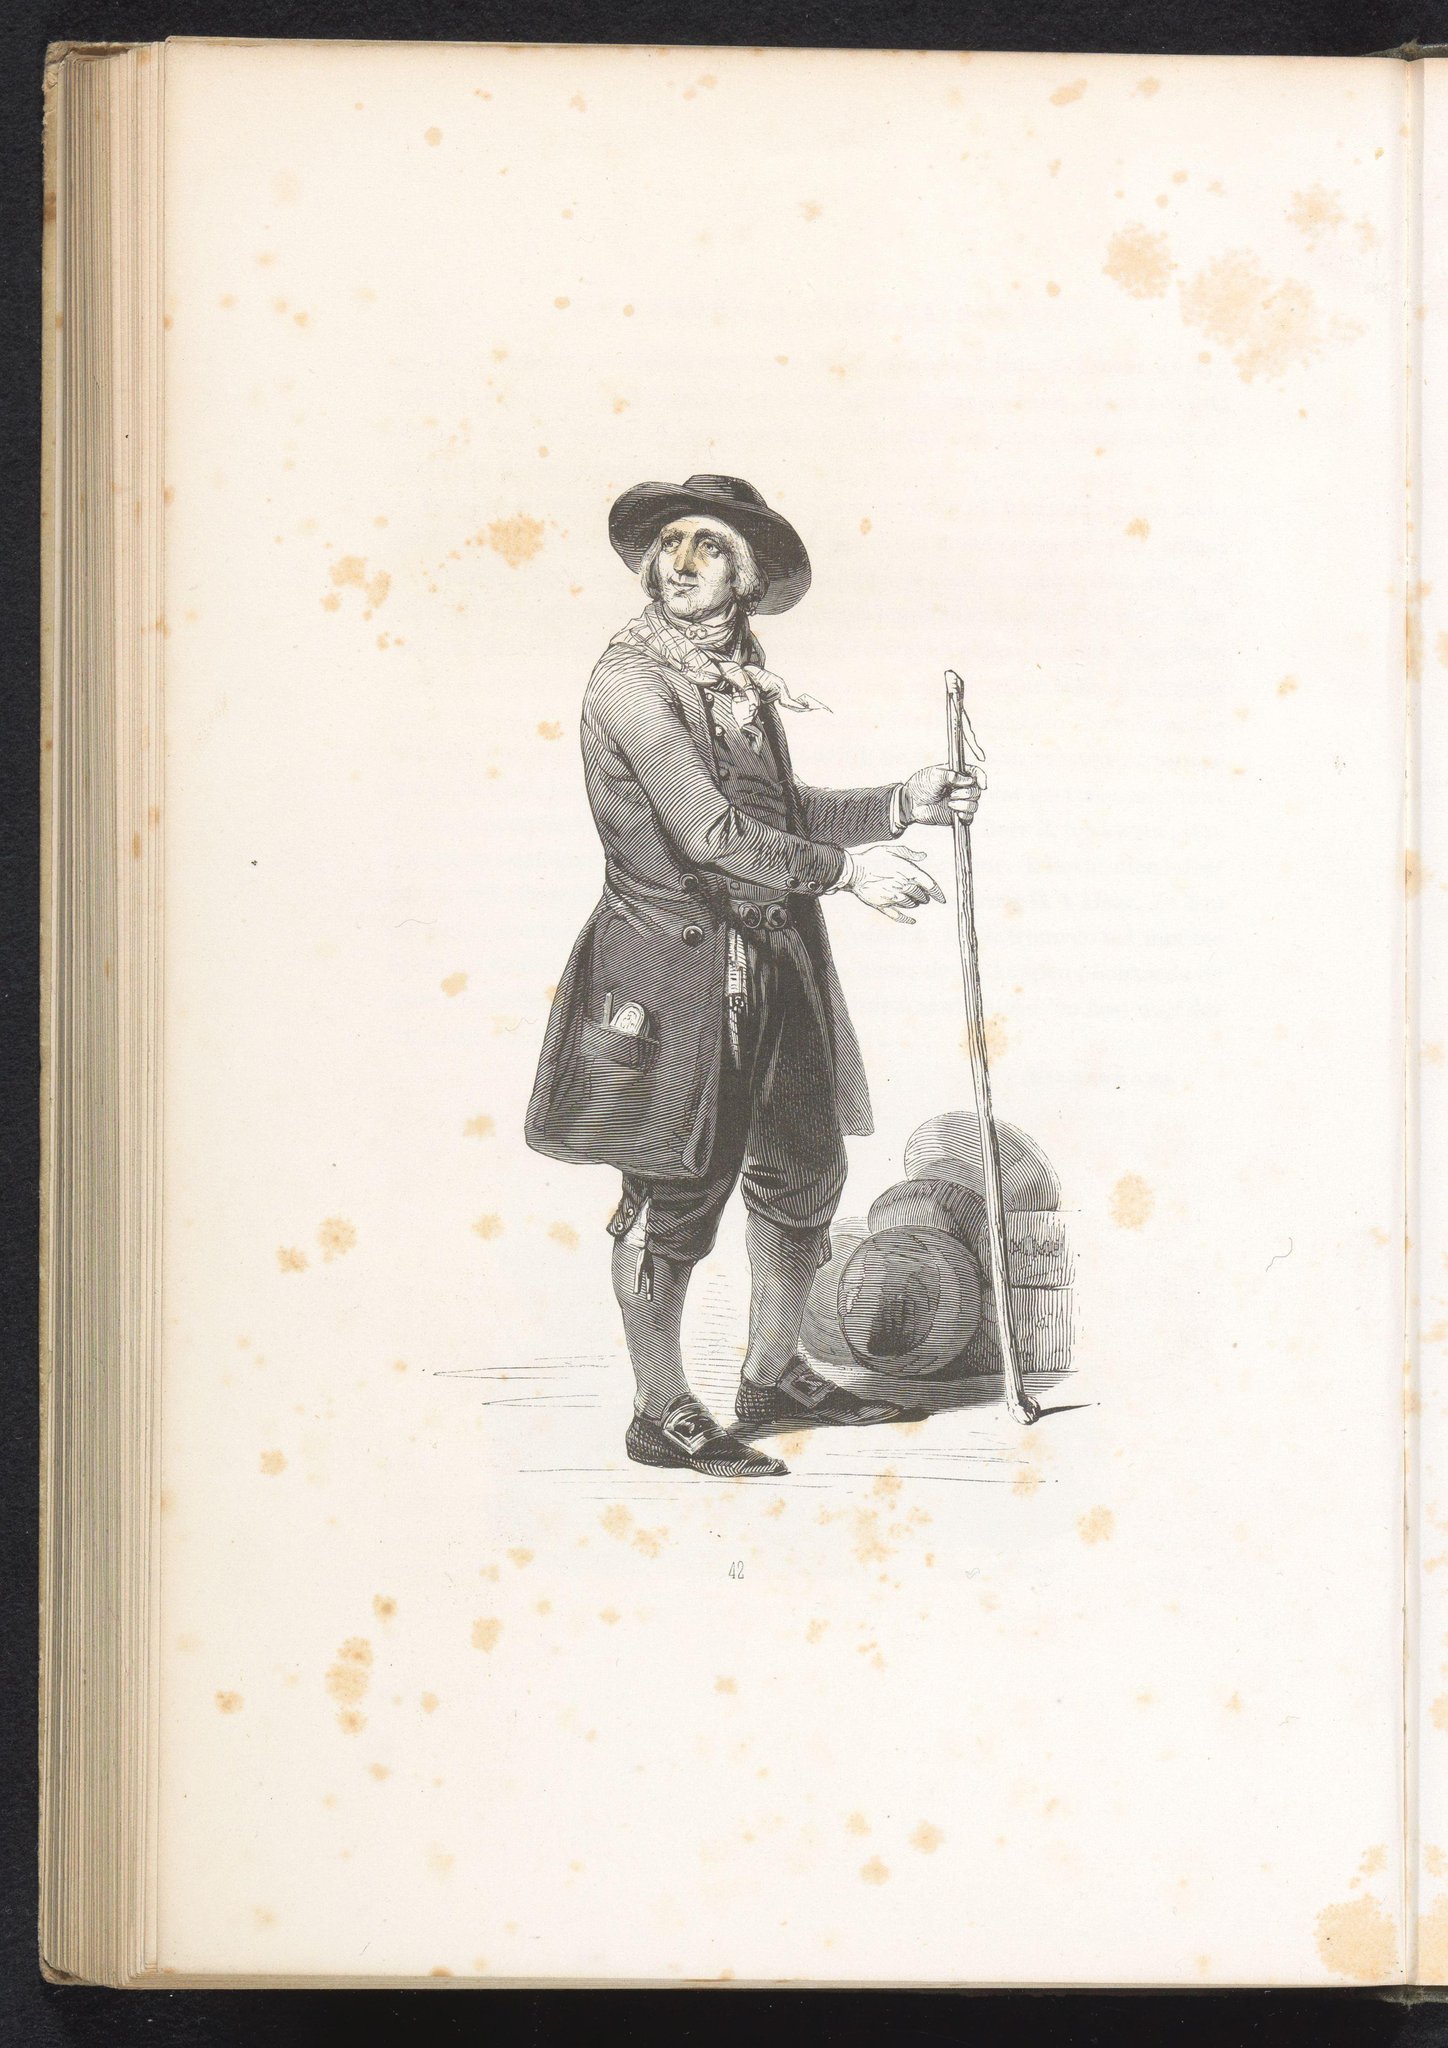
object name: print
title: De Noord-Hollandse boer, 1840-1841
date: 1841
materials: paper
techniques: letterpress printing, engraving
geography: netherlands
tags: professional clothes, farmers, folk costume, regional costume, cheese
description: De Noord-Hollandse boer. Staande man bij een stapel kazen. Genummerd: 42. Illustratie in het boek 'De Nederlanden: karakterschetsen, kleederdrachten, houding en voorkomen van verschillende standen', een boek met karakterschetsen, beroepen en klederdrachten van Nederlandse volkstypen uit 1841.